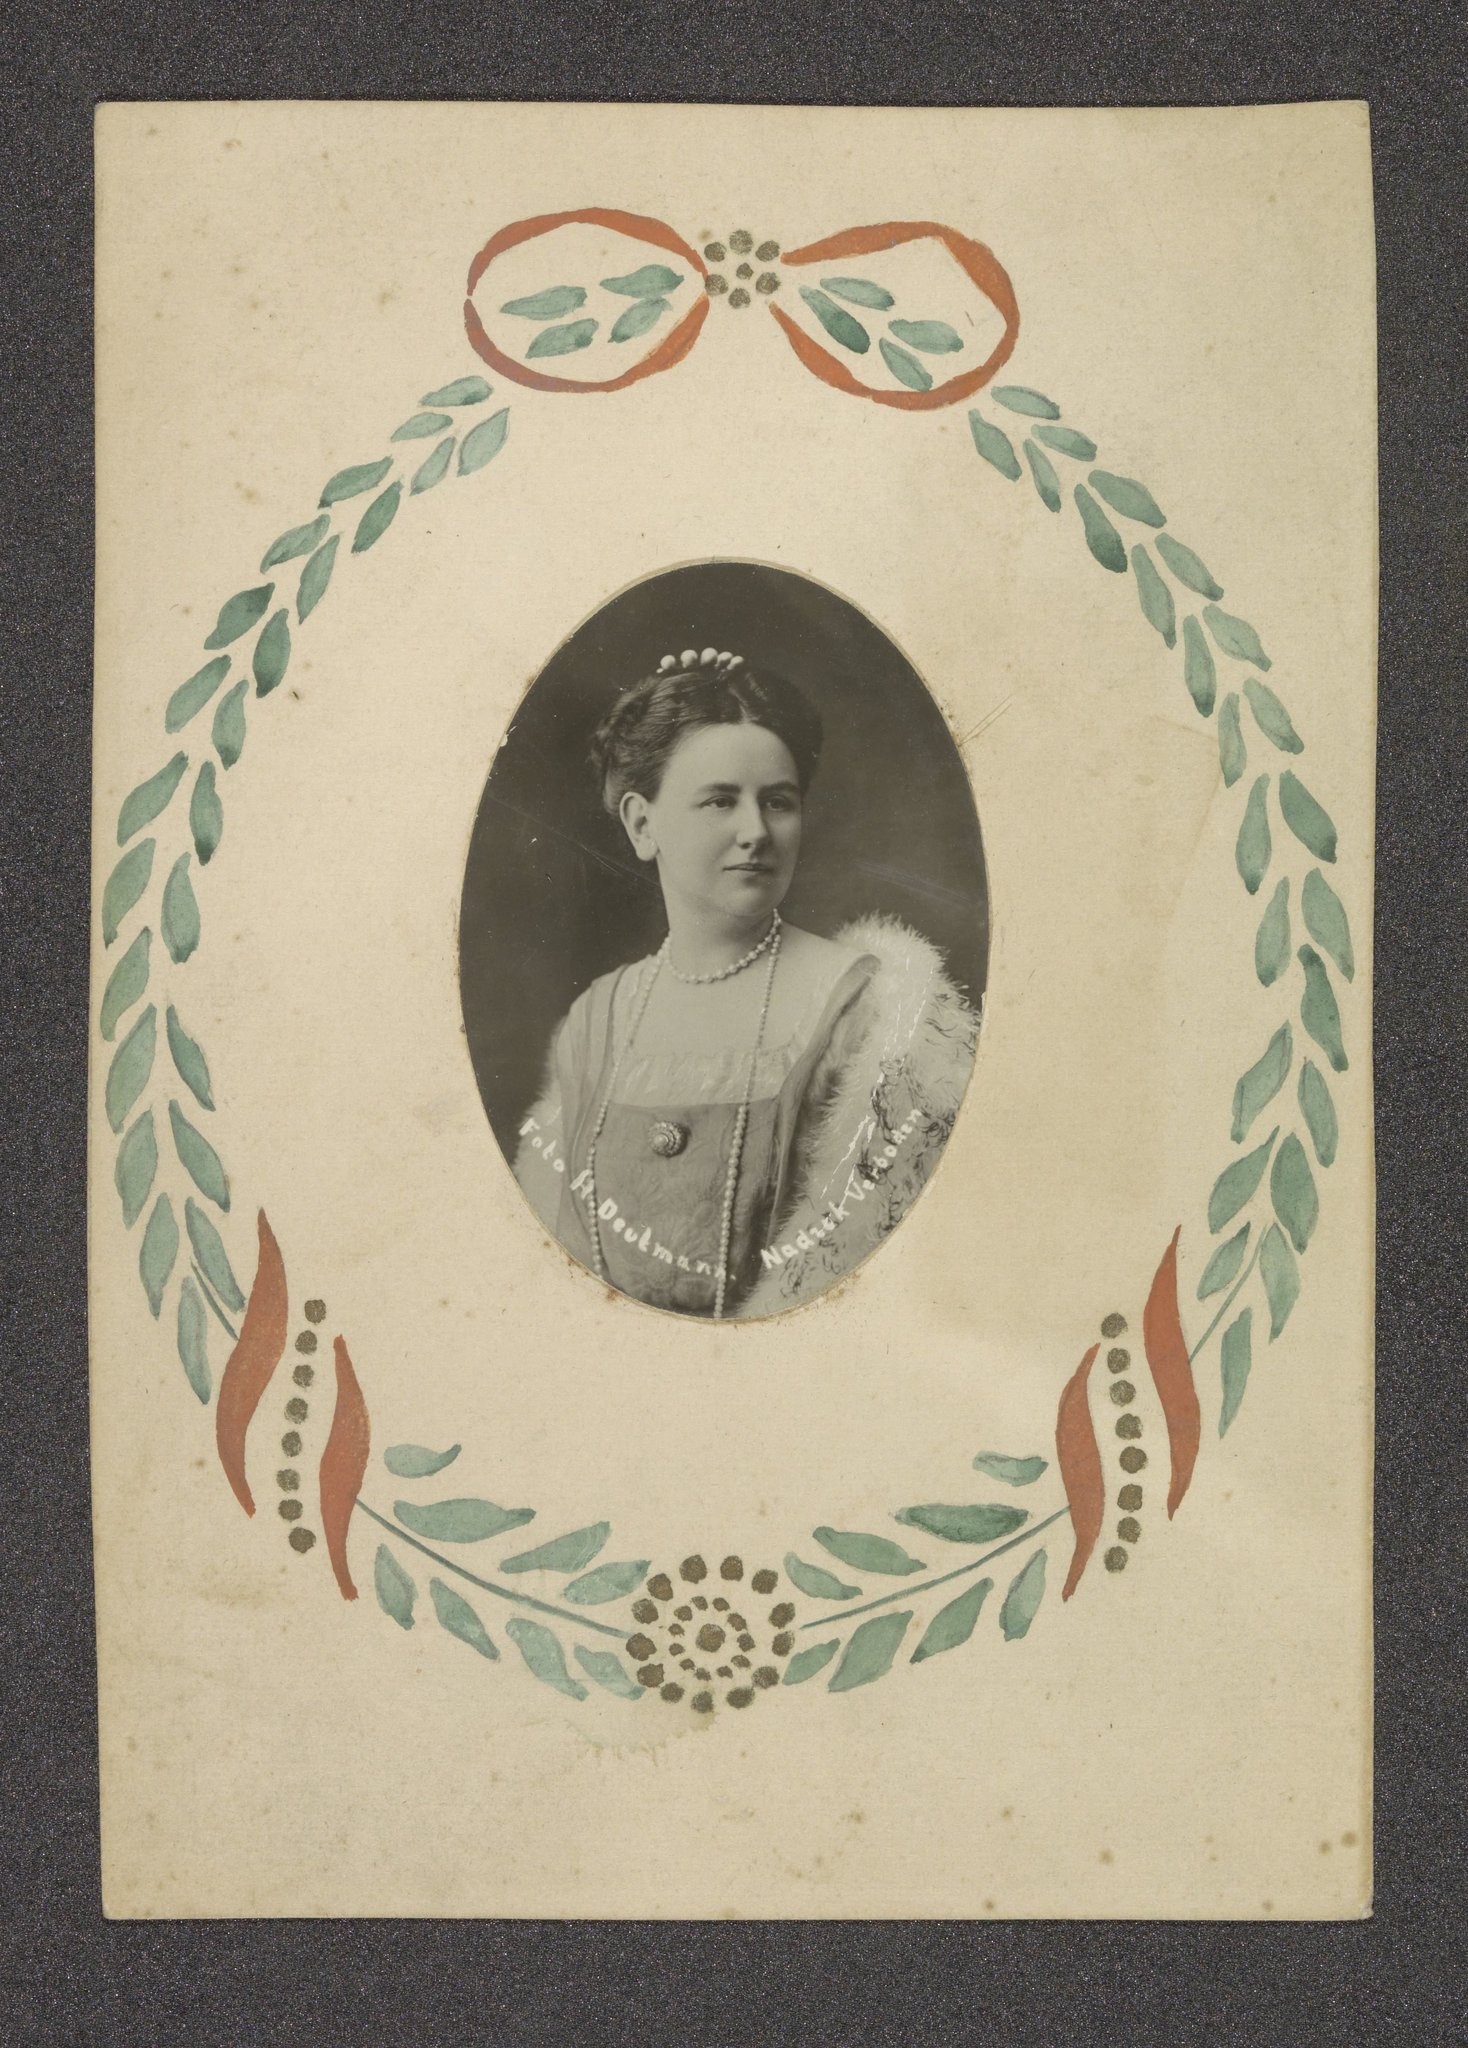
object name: photograph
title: Portret van koningin Wilhelmina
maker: herman deutmann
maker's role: fotograaf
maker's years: 1870-1926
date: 1895-1920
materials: photographic support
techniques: gelatin silver print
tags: the hague, print maker, wilhelmina of the netherlands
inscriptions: inscription: ‘foto niet in den handel, bureau steun comite Zwolle 1915’